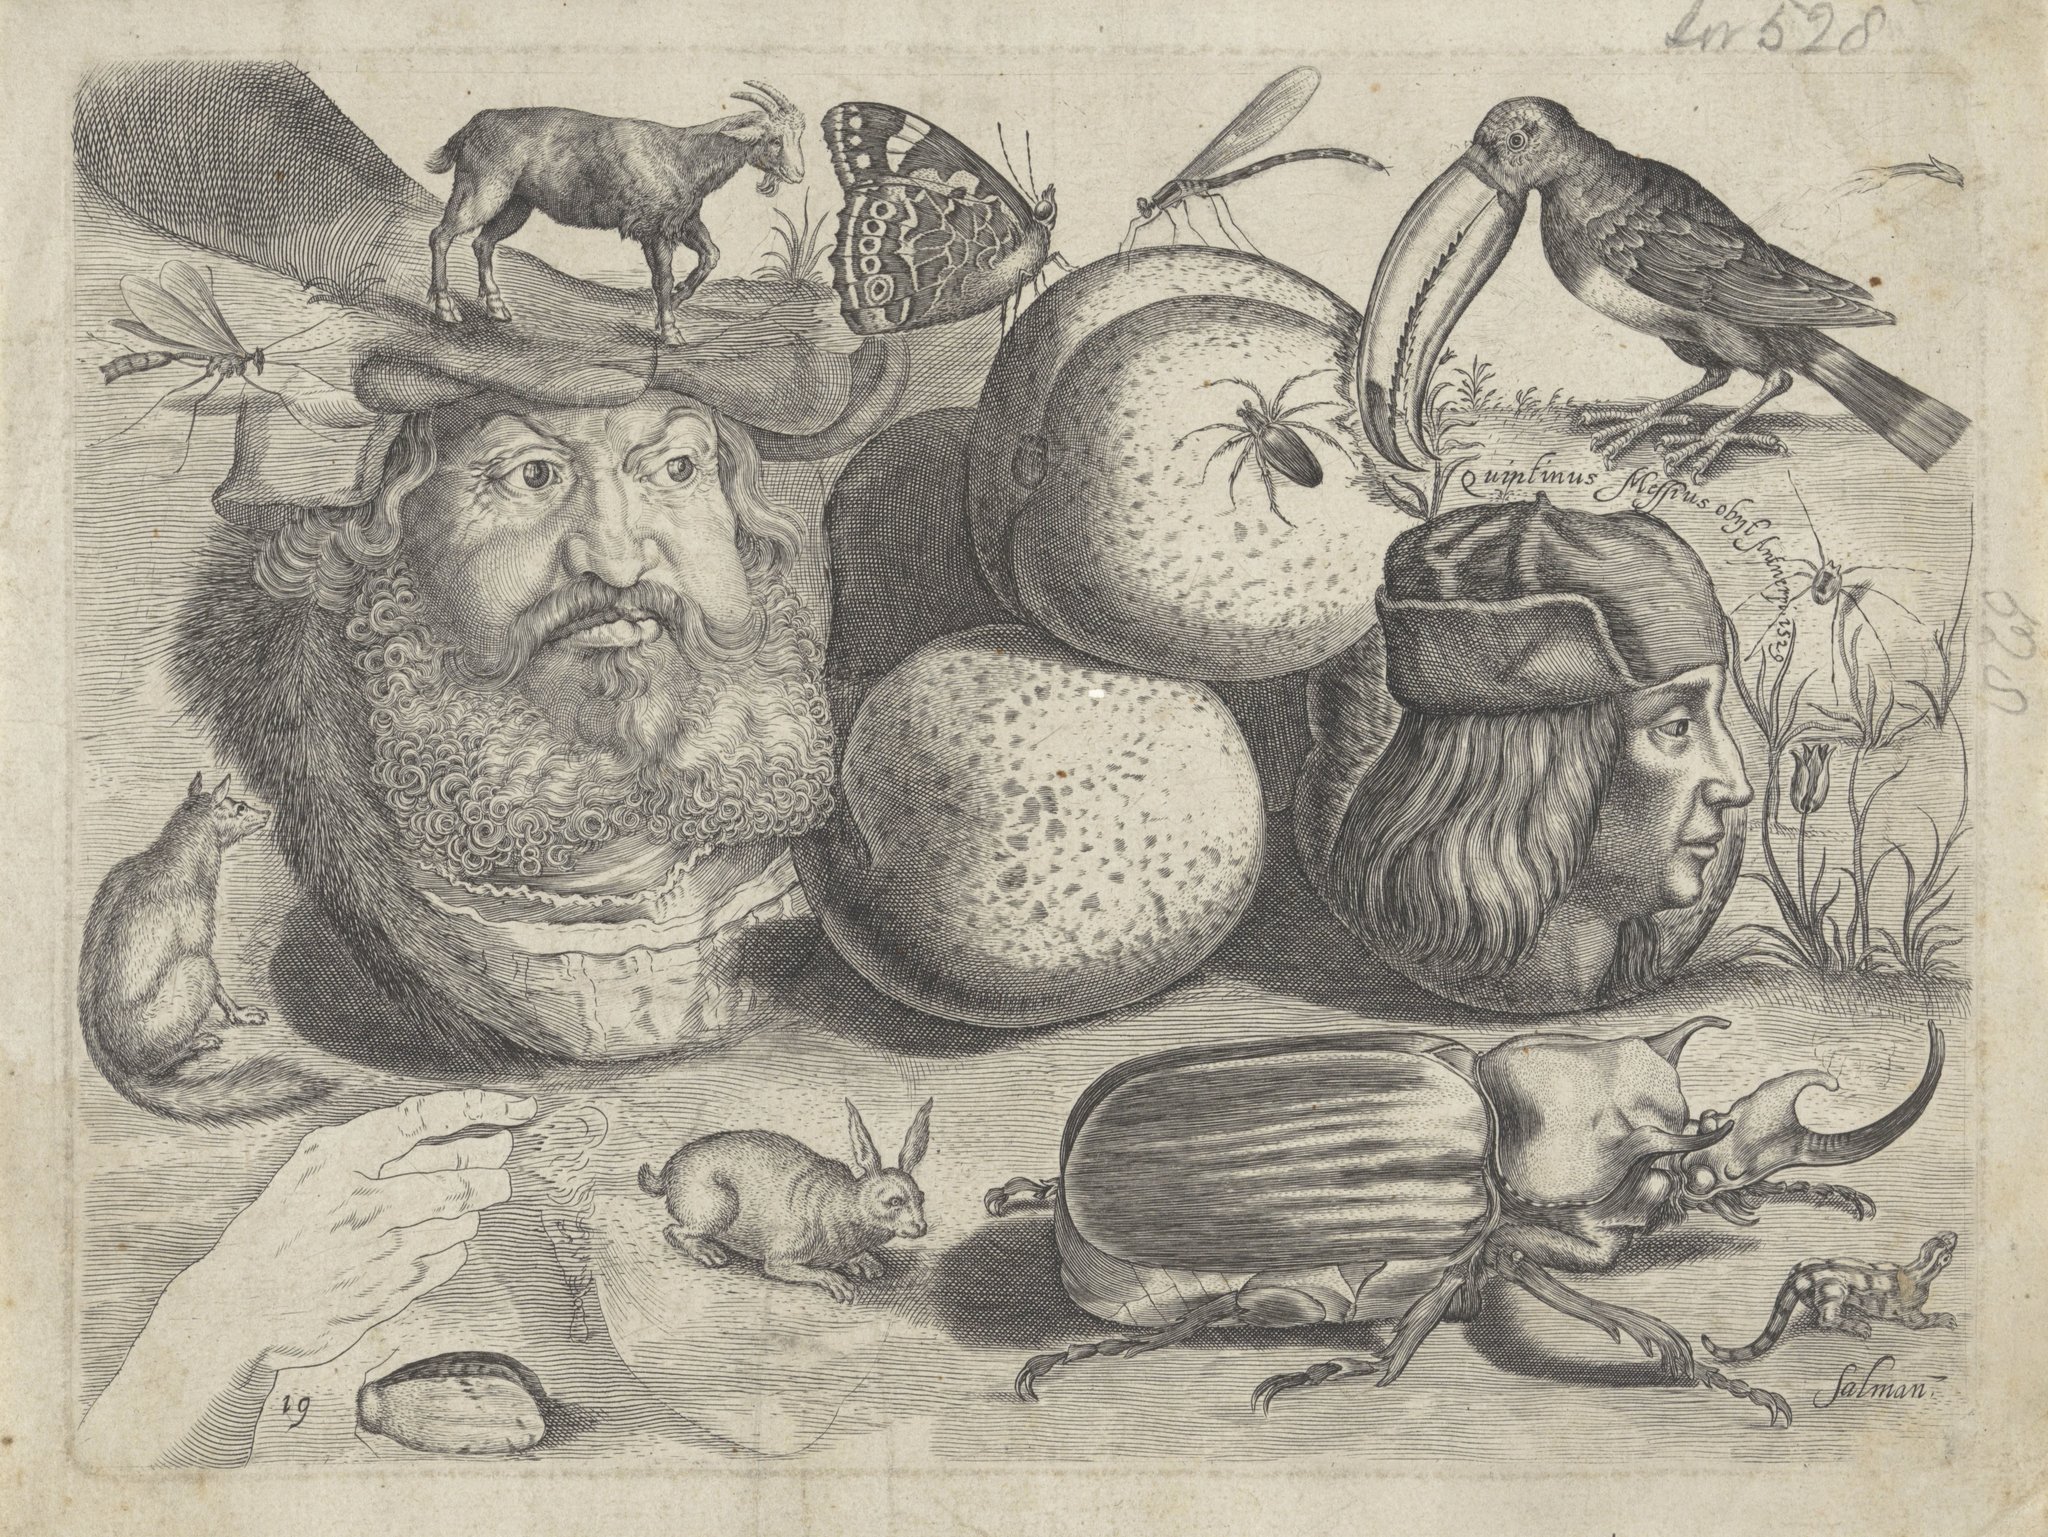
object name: print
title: Studieblad met tekenvoorbeelden: portretten, dieren, insecten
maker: michael snijders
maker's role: print maker, publisher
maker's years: 1586-1672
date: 1640-1660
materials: paper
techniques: engraving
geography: antwerp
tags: louvain, antwerp, painter, draughtsman, quinten massijs (i), london, print maker, anthony van dyck, head (human), model-books ~ implements of painter, beasts of prey, predatory animals, fruits: peach, flowers: tulip, goat, insects, other birds: toucan, insects: beetle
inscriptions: collector's mark: Lugt 2760, collector's mark: Lugt 2228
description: Negentiende prent uit een serie tekenvoorbeelden van onbekende omvang. Studieblad met koppen, dieren en insecten. In het midden twee portretten, van links naar rechts: Frederik III de Wijze ( keurvorst van Saksen) en Quinten Massijs (de laatste met zijn naam, sterfplaats en -jaar). Daartussen twee perziken. Rondom de portretten diverse dieren en insecten waaronder een toekan (naar illustratie in Gessner), vos, haas (naar Aegidius Sadeler) en olifantskever en vlinder (naar Hoefnagel).